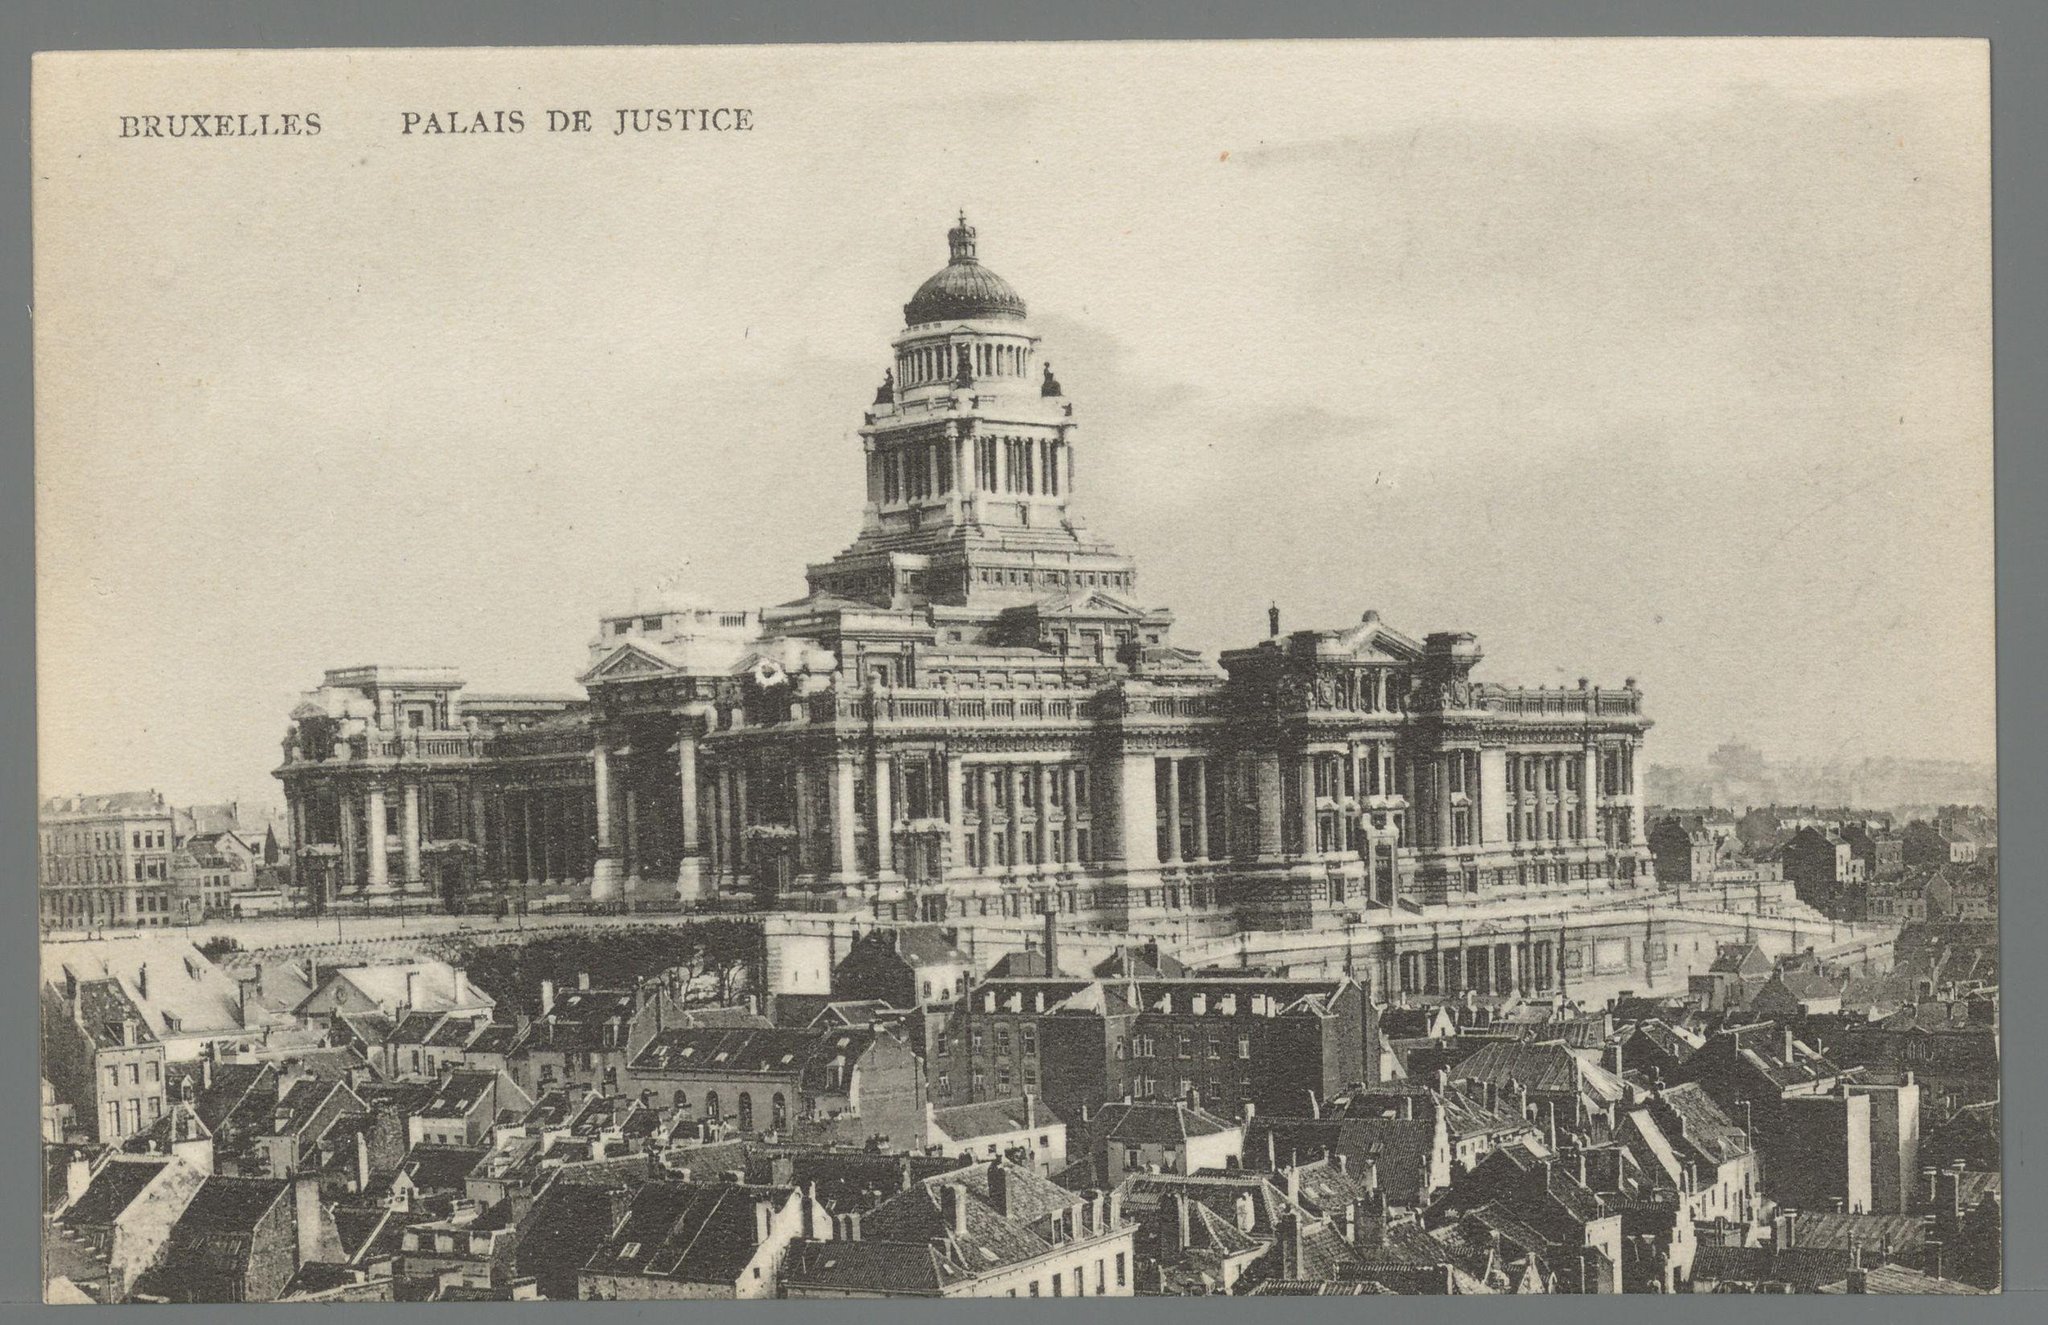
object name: ansichtkaart, prentbriefkaart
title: Bruxelles. Palais de Justice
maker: Anonymous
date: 1906-1930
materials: cardboard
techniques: photograph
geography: brussels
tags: court building, city-view, and landscape with man-made constructions